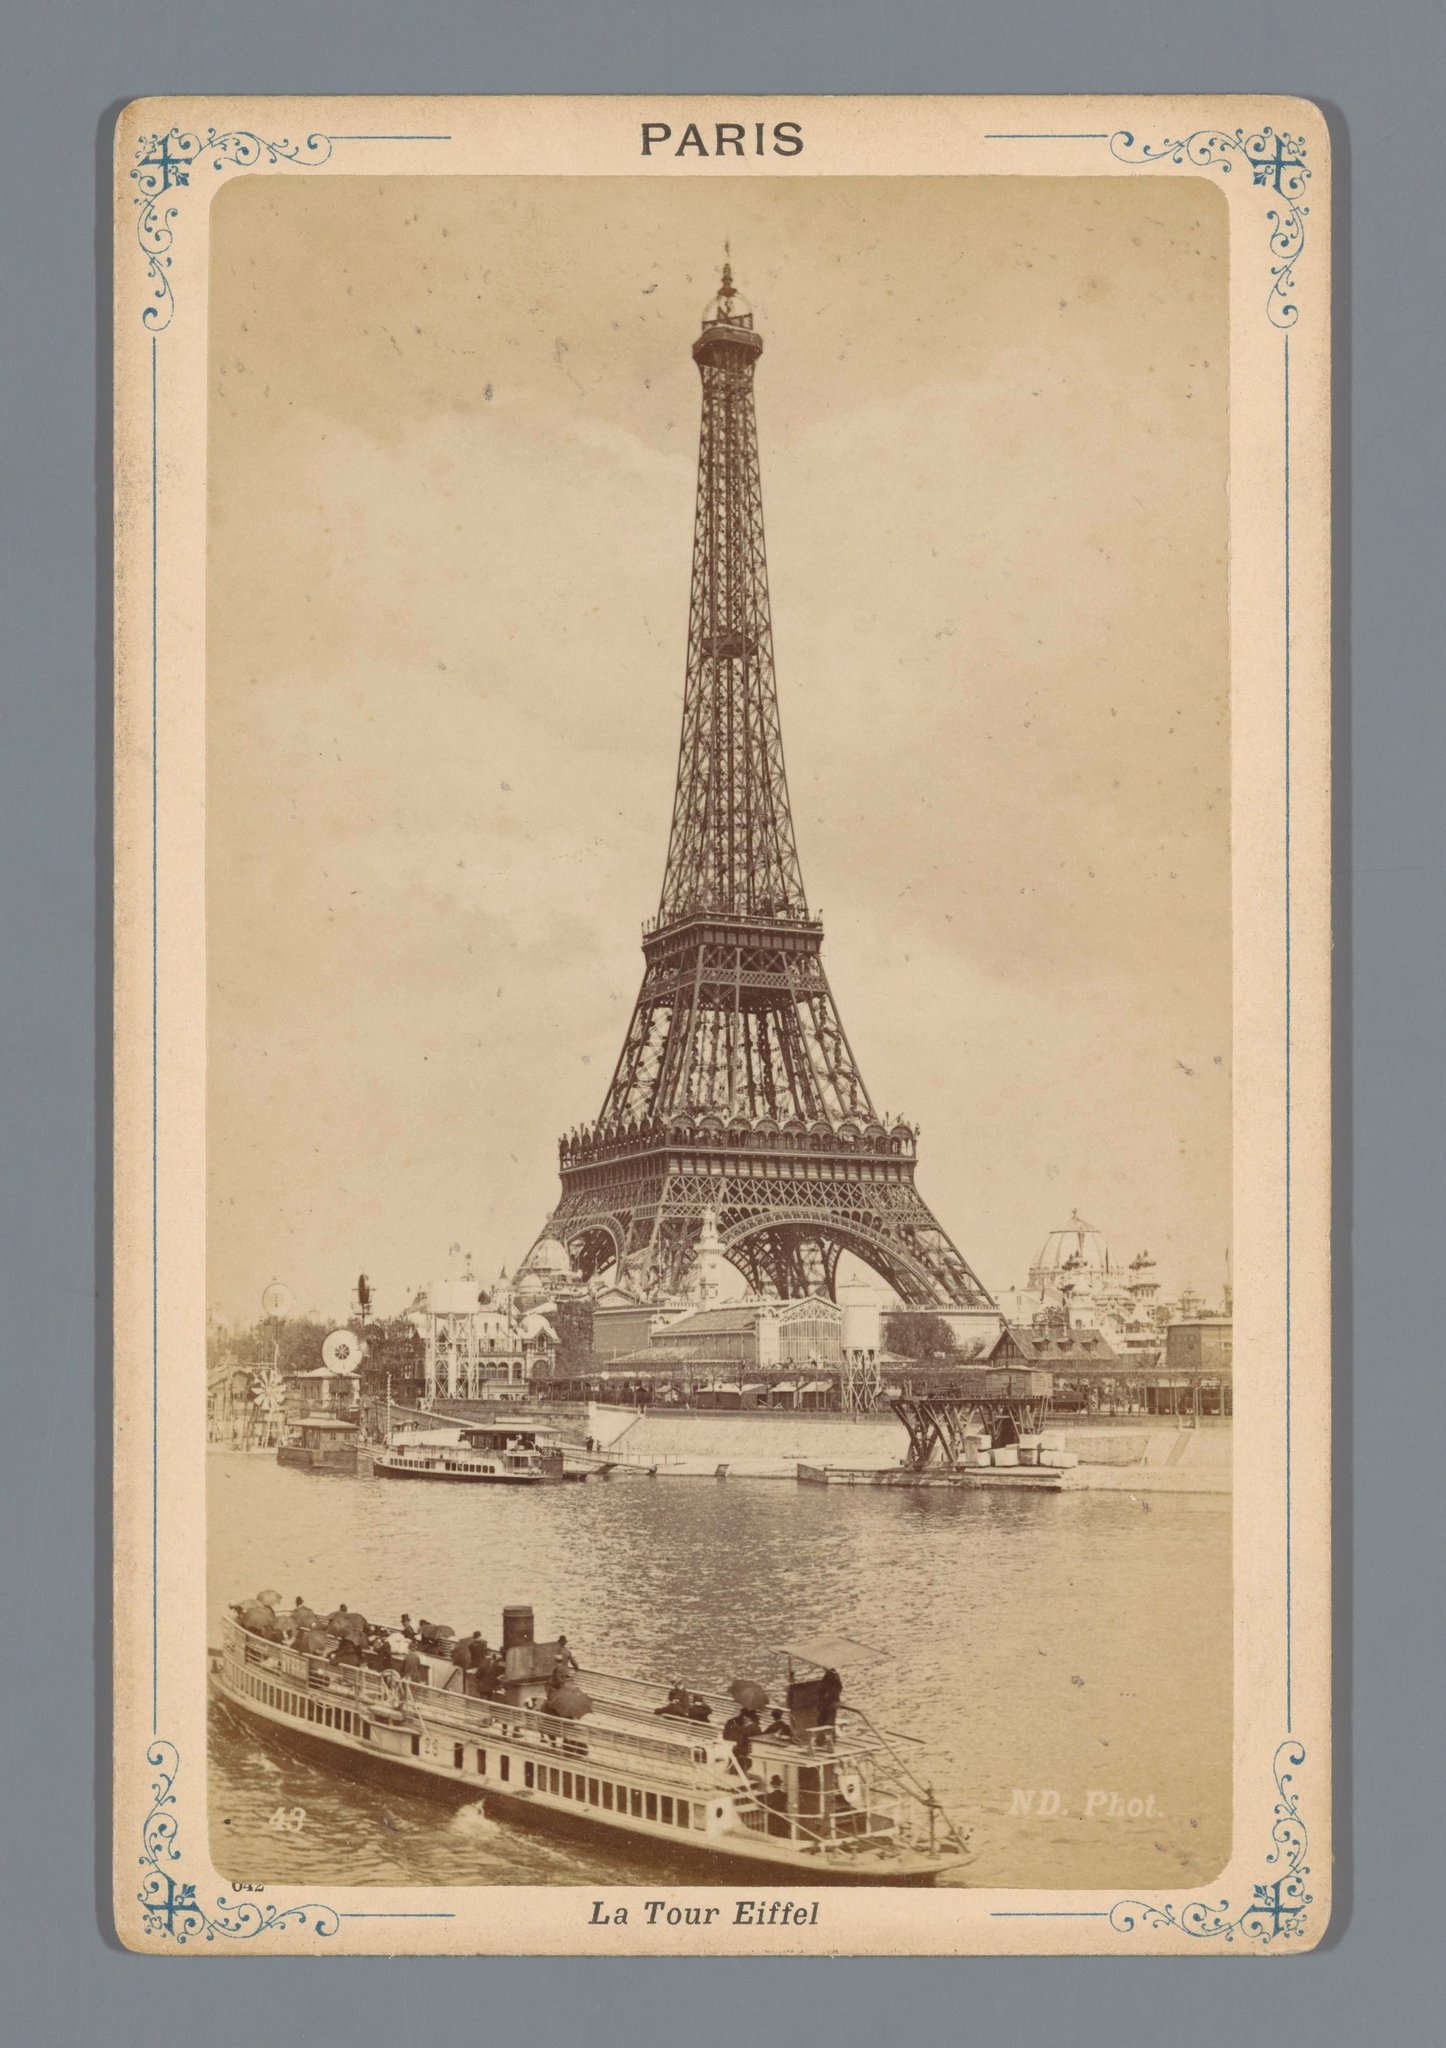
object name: photograph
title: Gezicht op de Eiffeltoren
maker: étienne neurdein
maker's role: publisher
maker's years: 1832-1918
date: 1870-1900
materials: cardboard, photographic support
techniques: albumen print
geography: paris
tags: tower, clock tower ~ monumental adornment, eiffel tower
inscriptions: inscription: ‘43/ N.D. Phot.’, retailer's mark: ‘VUES DE PARIS/ F. HELAINE/ 206, Rude de Rivoli/ PARIS/ Monocles-Graphoscopes’